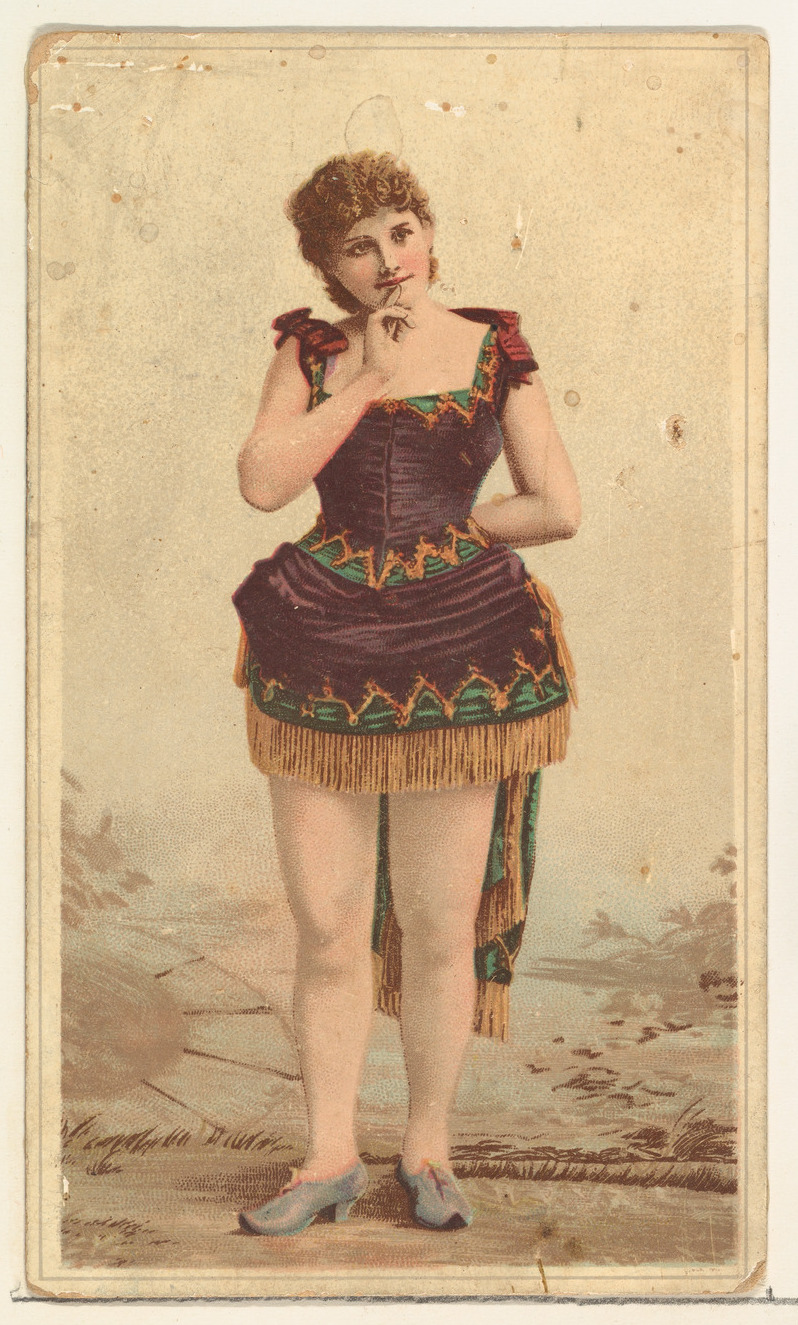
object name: print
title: Actress posing pensively with hand held to lips, from Stars of the Stage, Second Series (N130) issued by Duke Sons & Co. to promote Honest Long Cut Tobacco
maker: w. duke, sons & co.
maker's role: publisher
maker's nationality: american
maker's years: 1870-1920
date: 1891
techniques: color lithograph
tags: portraits,women,actresses